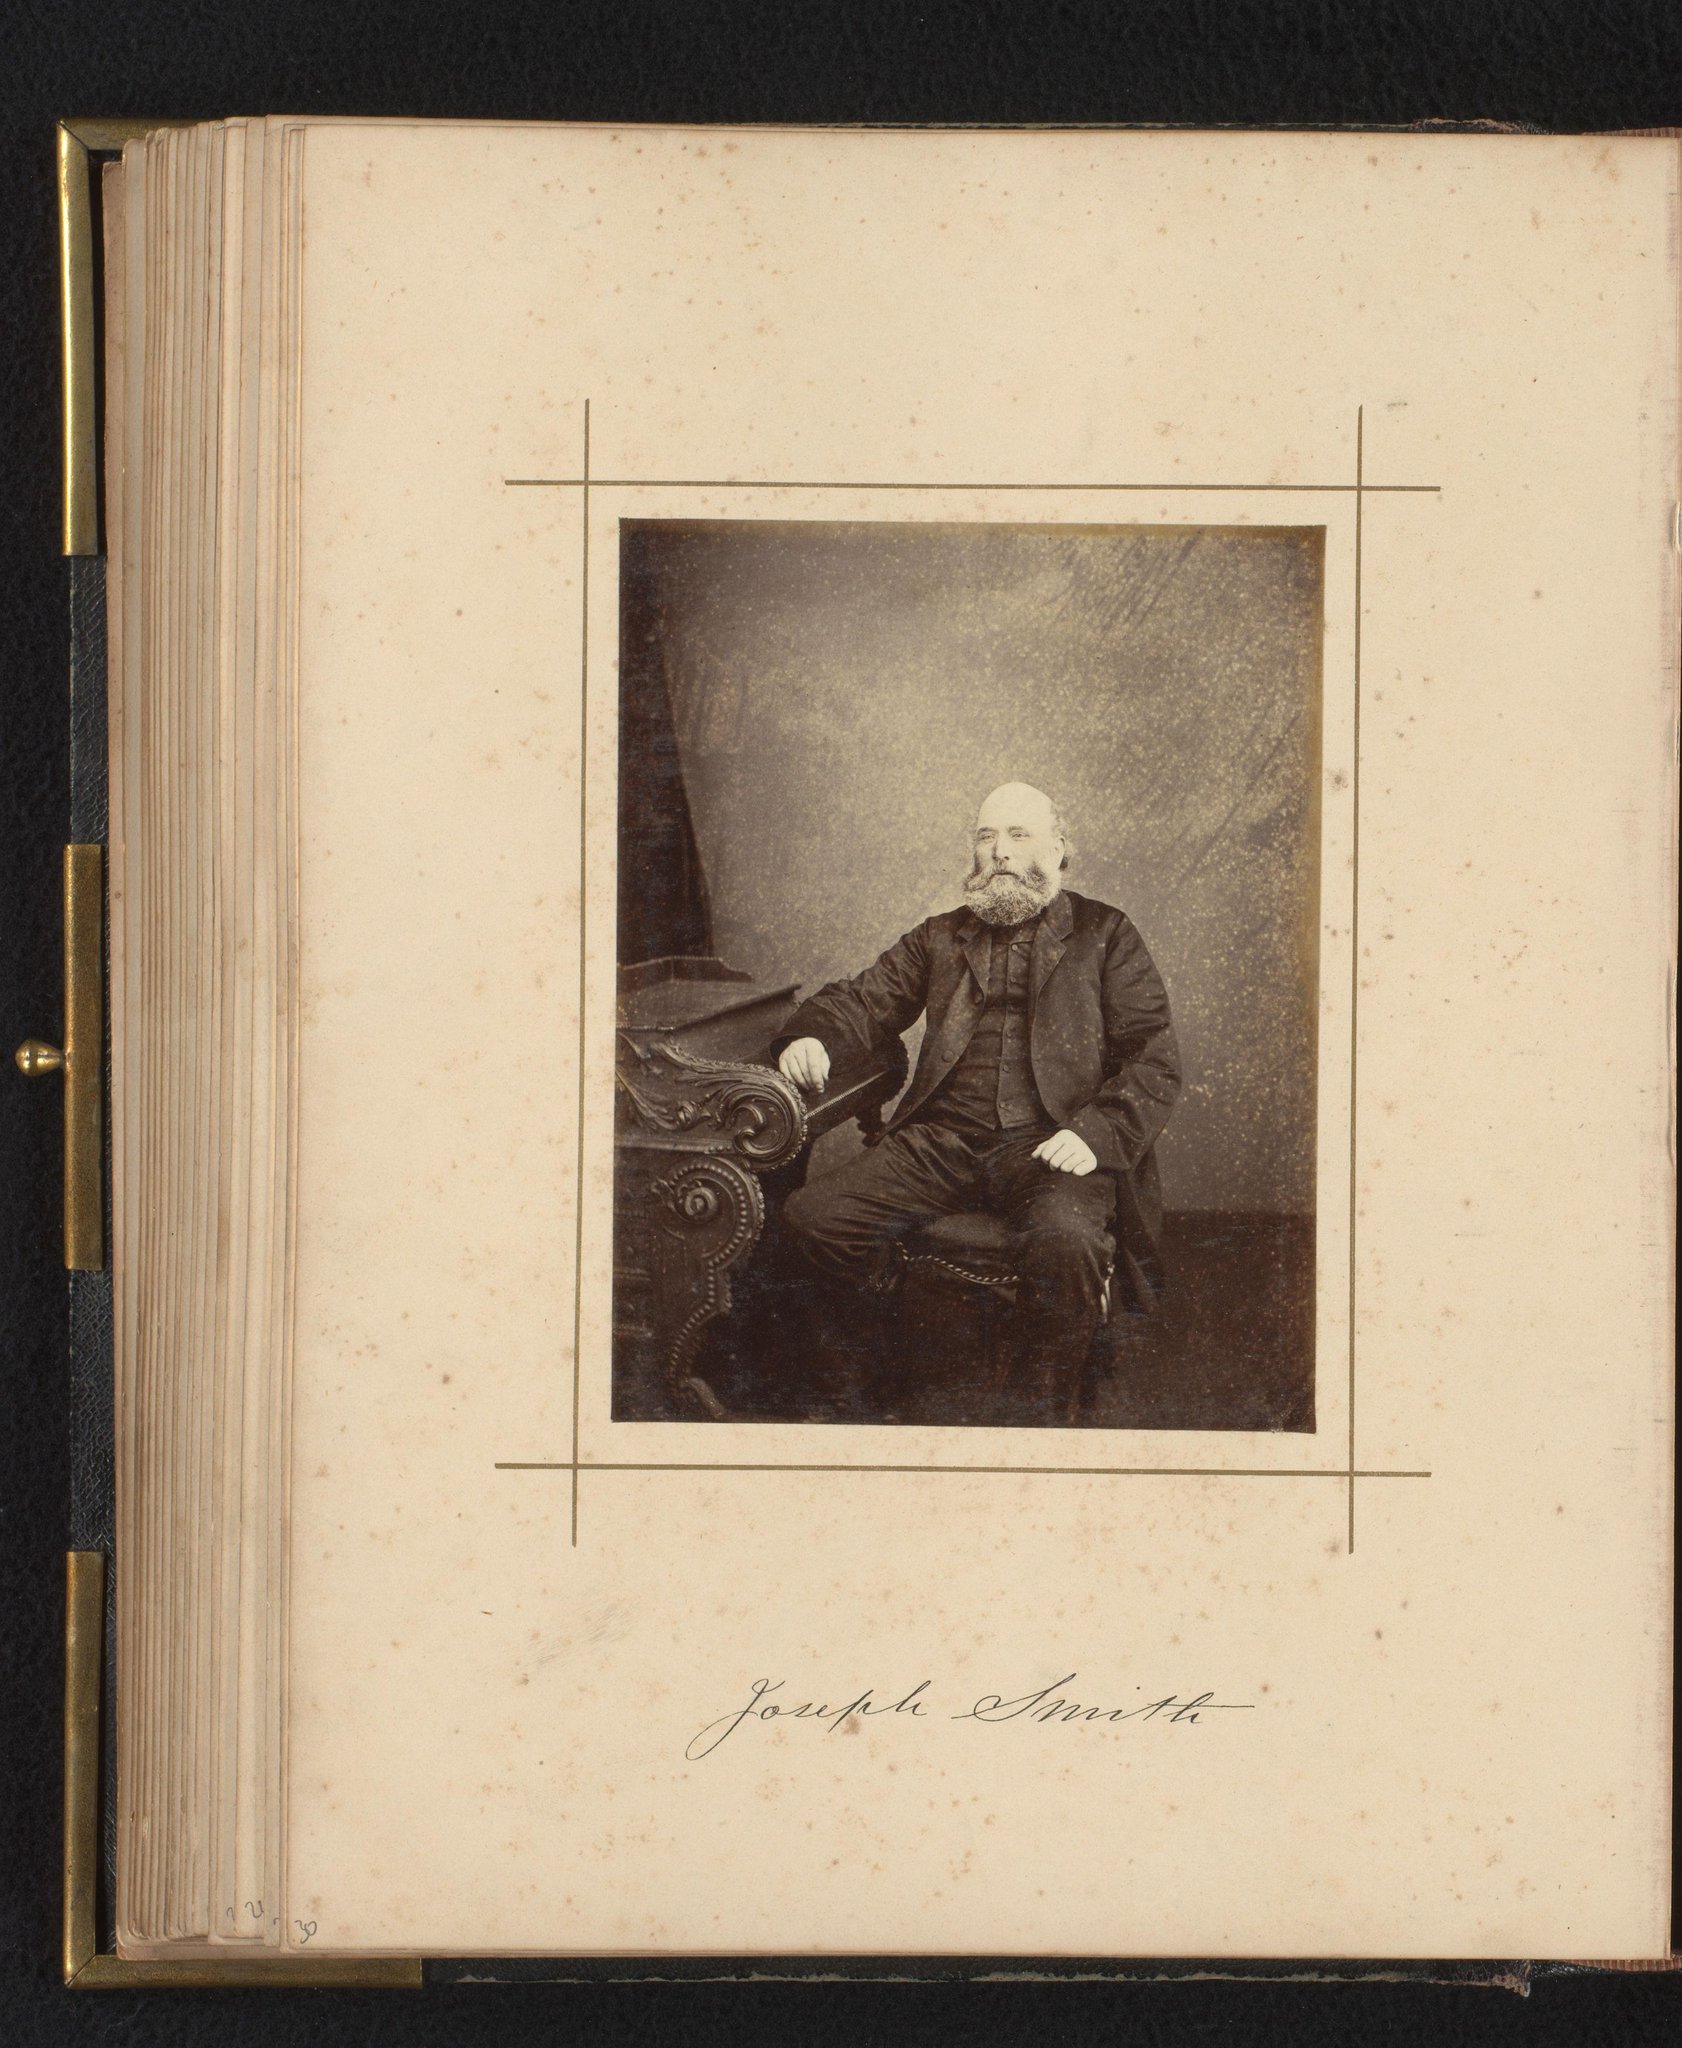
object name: photograph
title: Portret van Joseph Smith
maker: Anonymous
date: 1866-1871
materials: photographic support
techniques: albumen print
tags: sitting figure, historical persons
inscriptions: name: ‘Joseph Smith’